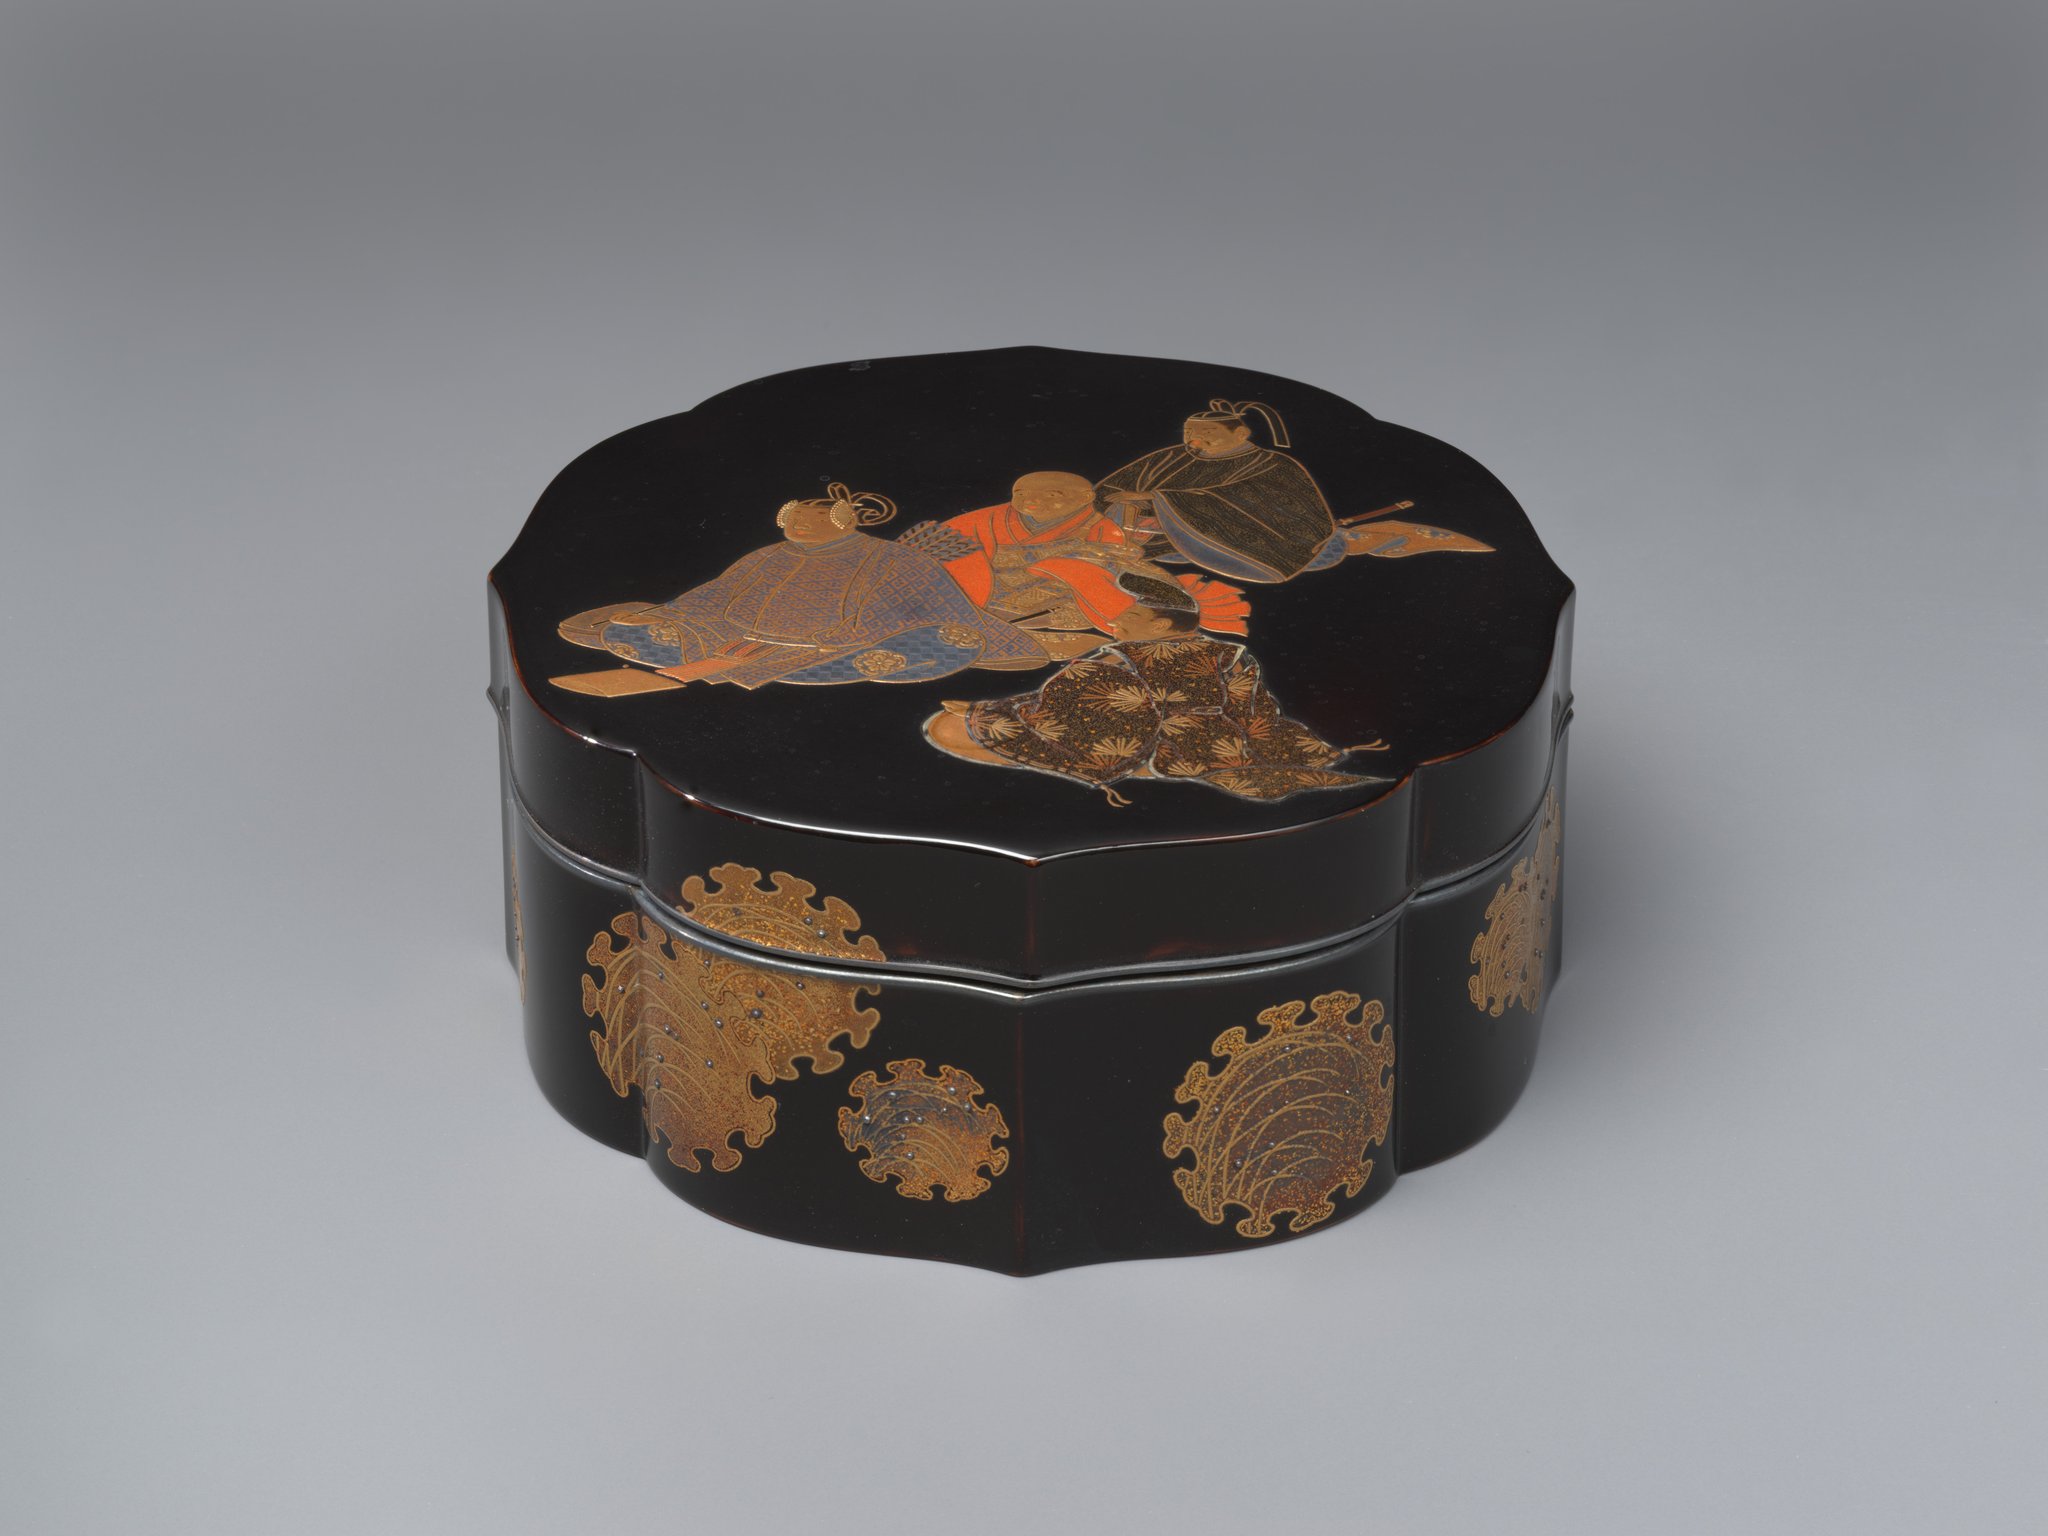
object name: box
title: Box depicting Rokkasen (The Six Court Poets)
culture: japanese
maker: ganshosai shunsui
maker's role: artist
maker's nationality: japanese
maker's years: 1822-1880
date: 1801-1900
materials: gold, lacquer